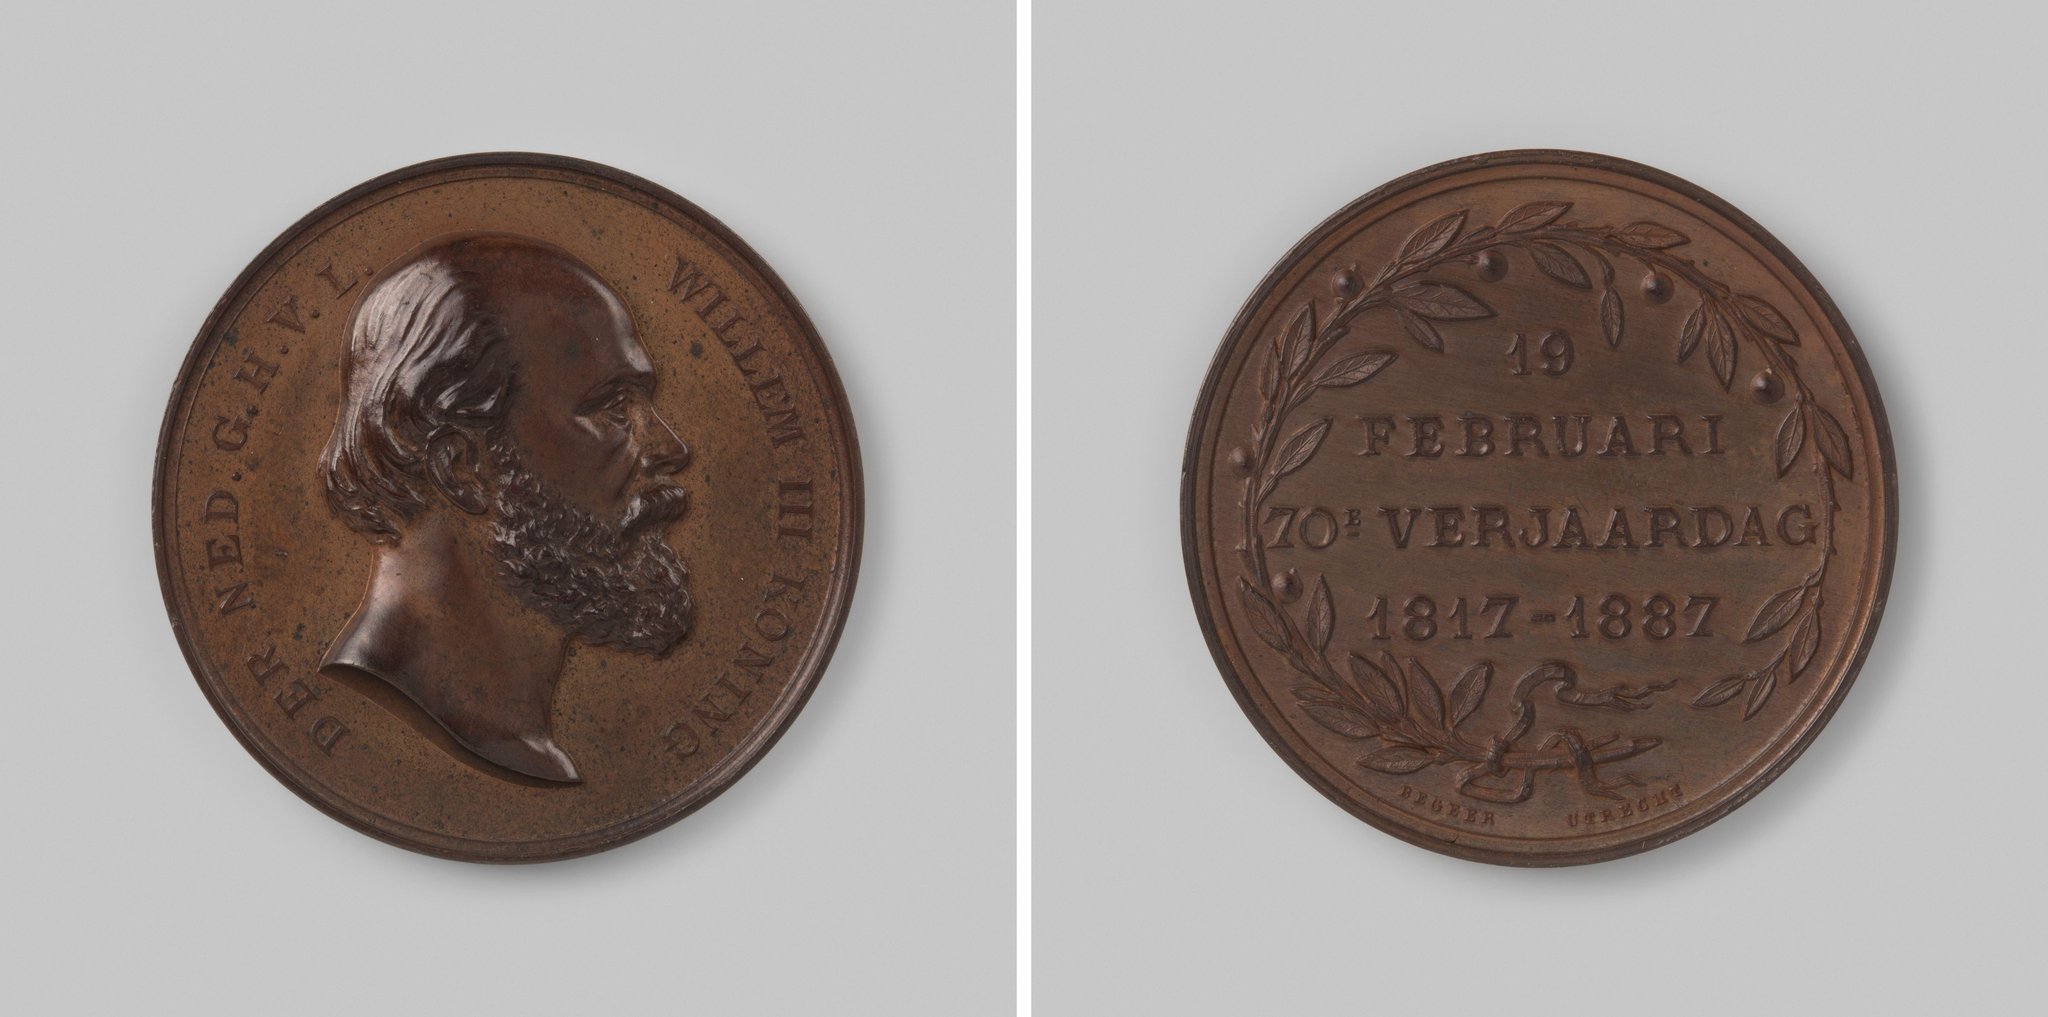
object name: history medal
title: Zeventigste verjaardag van Koning Willem III 1887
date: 1887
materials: bronze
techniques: striking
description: Bronzen penning, op de voorzijde het portret van Willem III naar rechts met omschrift, op de keerzijde vier regels tekst binnen een rondgebogen lauwertak.